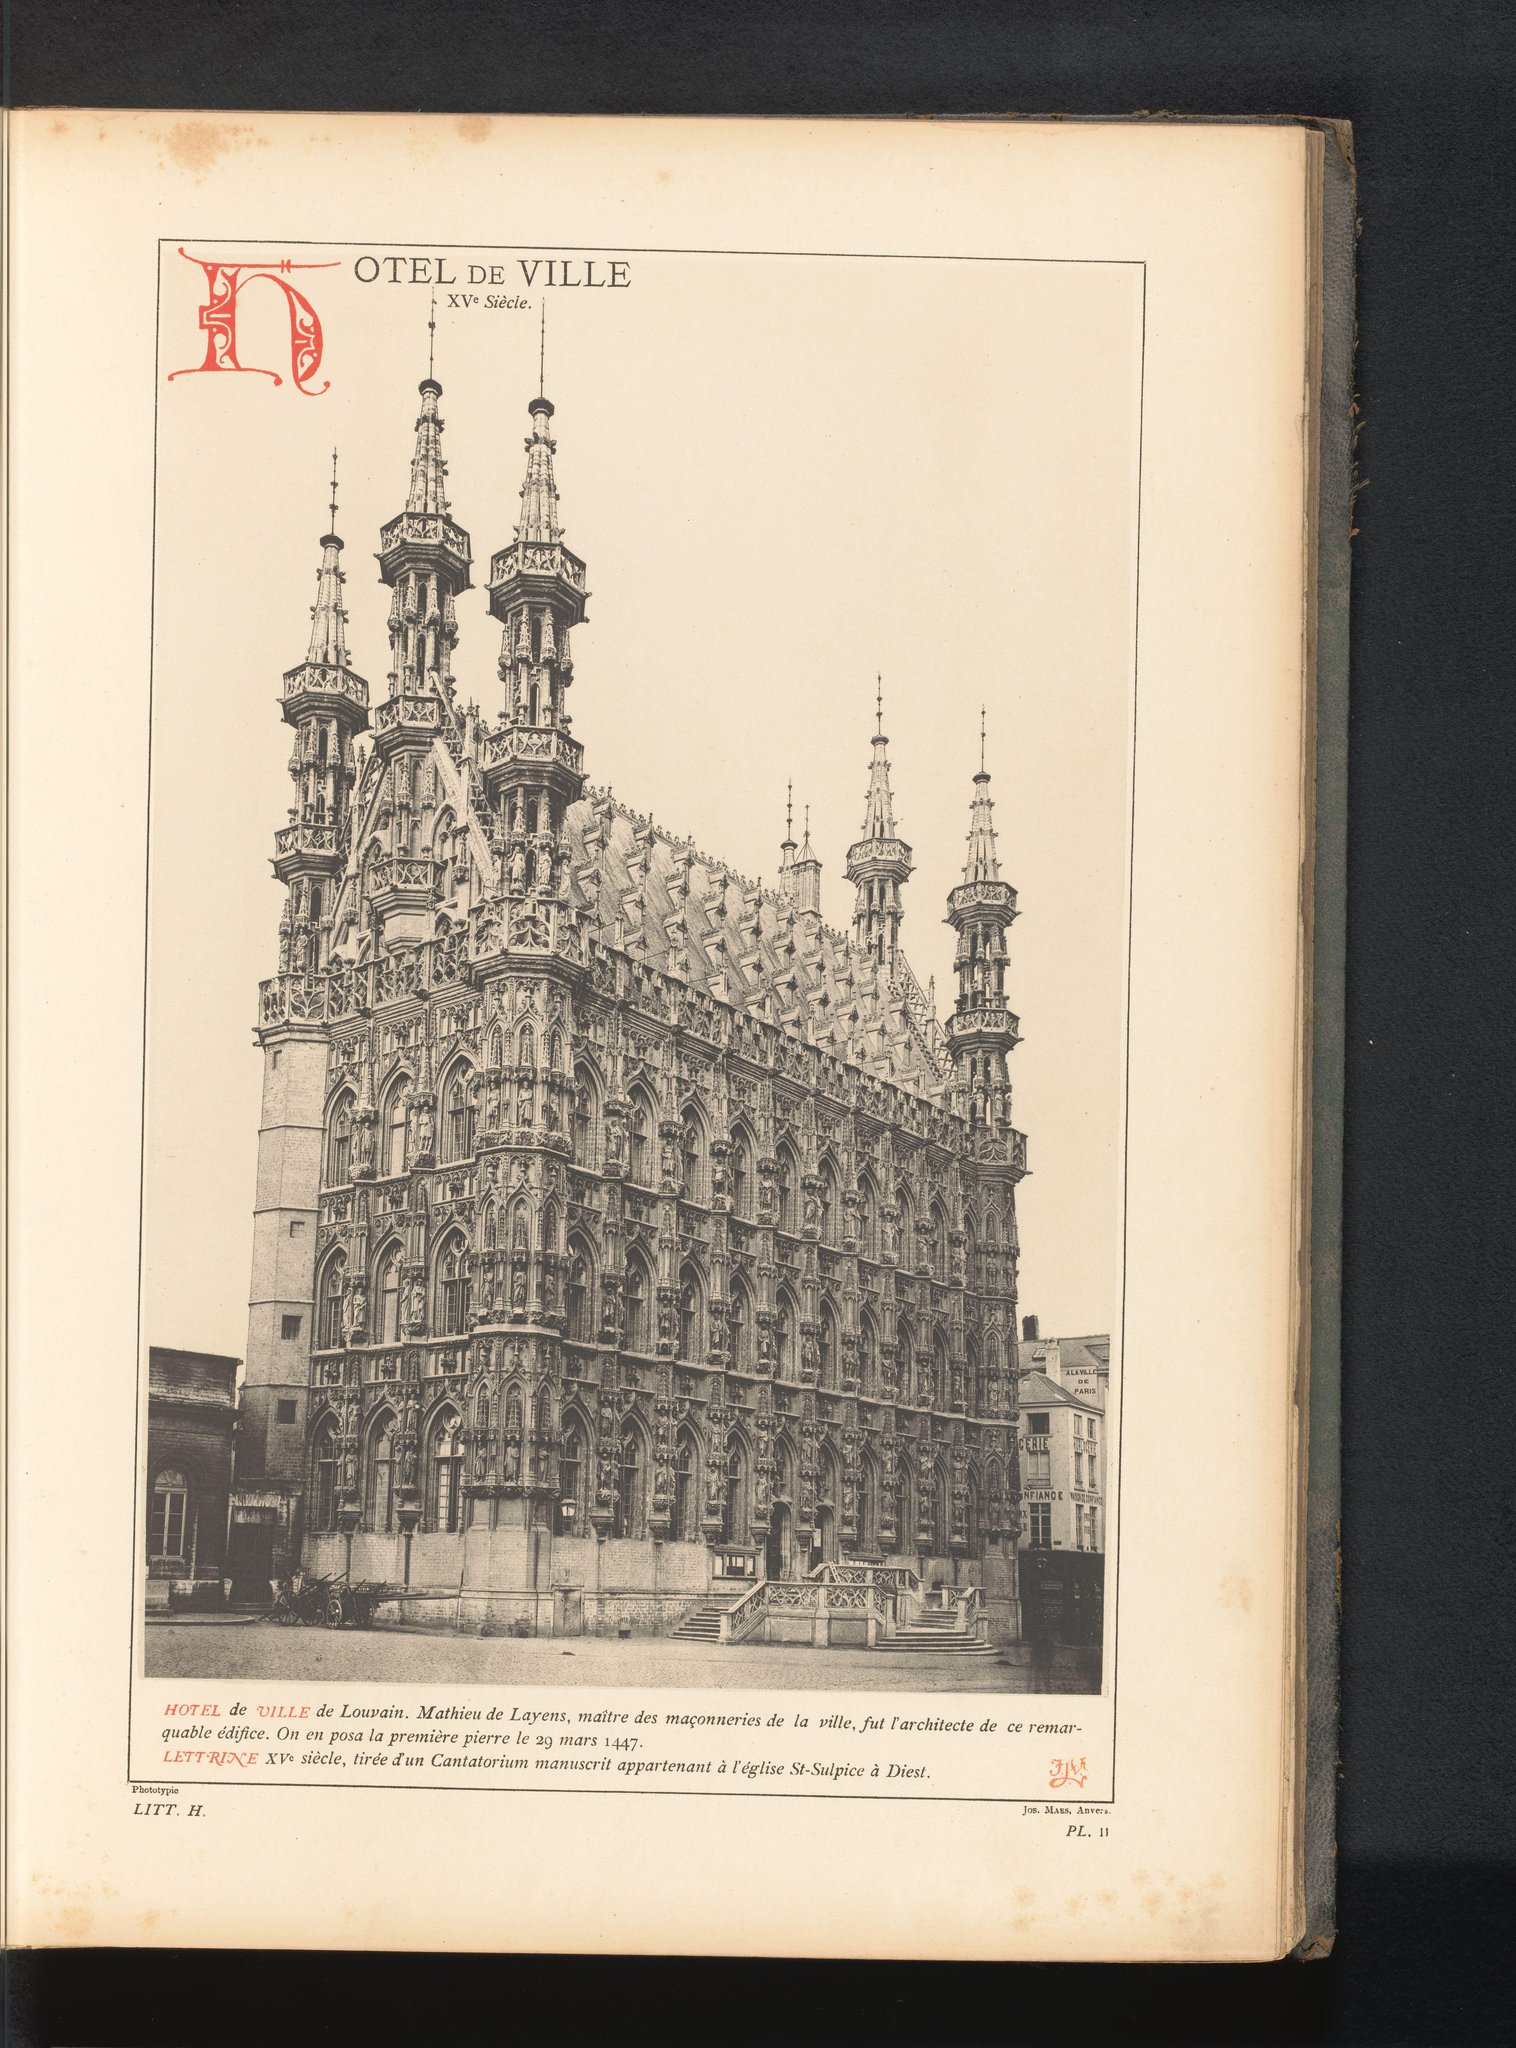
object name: page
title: Gezicht op het stadhuis van Leuven, België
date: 1875-1880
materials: paper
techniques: photograph, photolithography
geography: leuven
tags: townhall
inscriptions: inscription: ‘HOTEL de VILLE (...)’, monogram: ‘JJvY’, inscription: ‘LITT. H. - PL. 11’